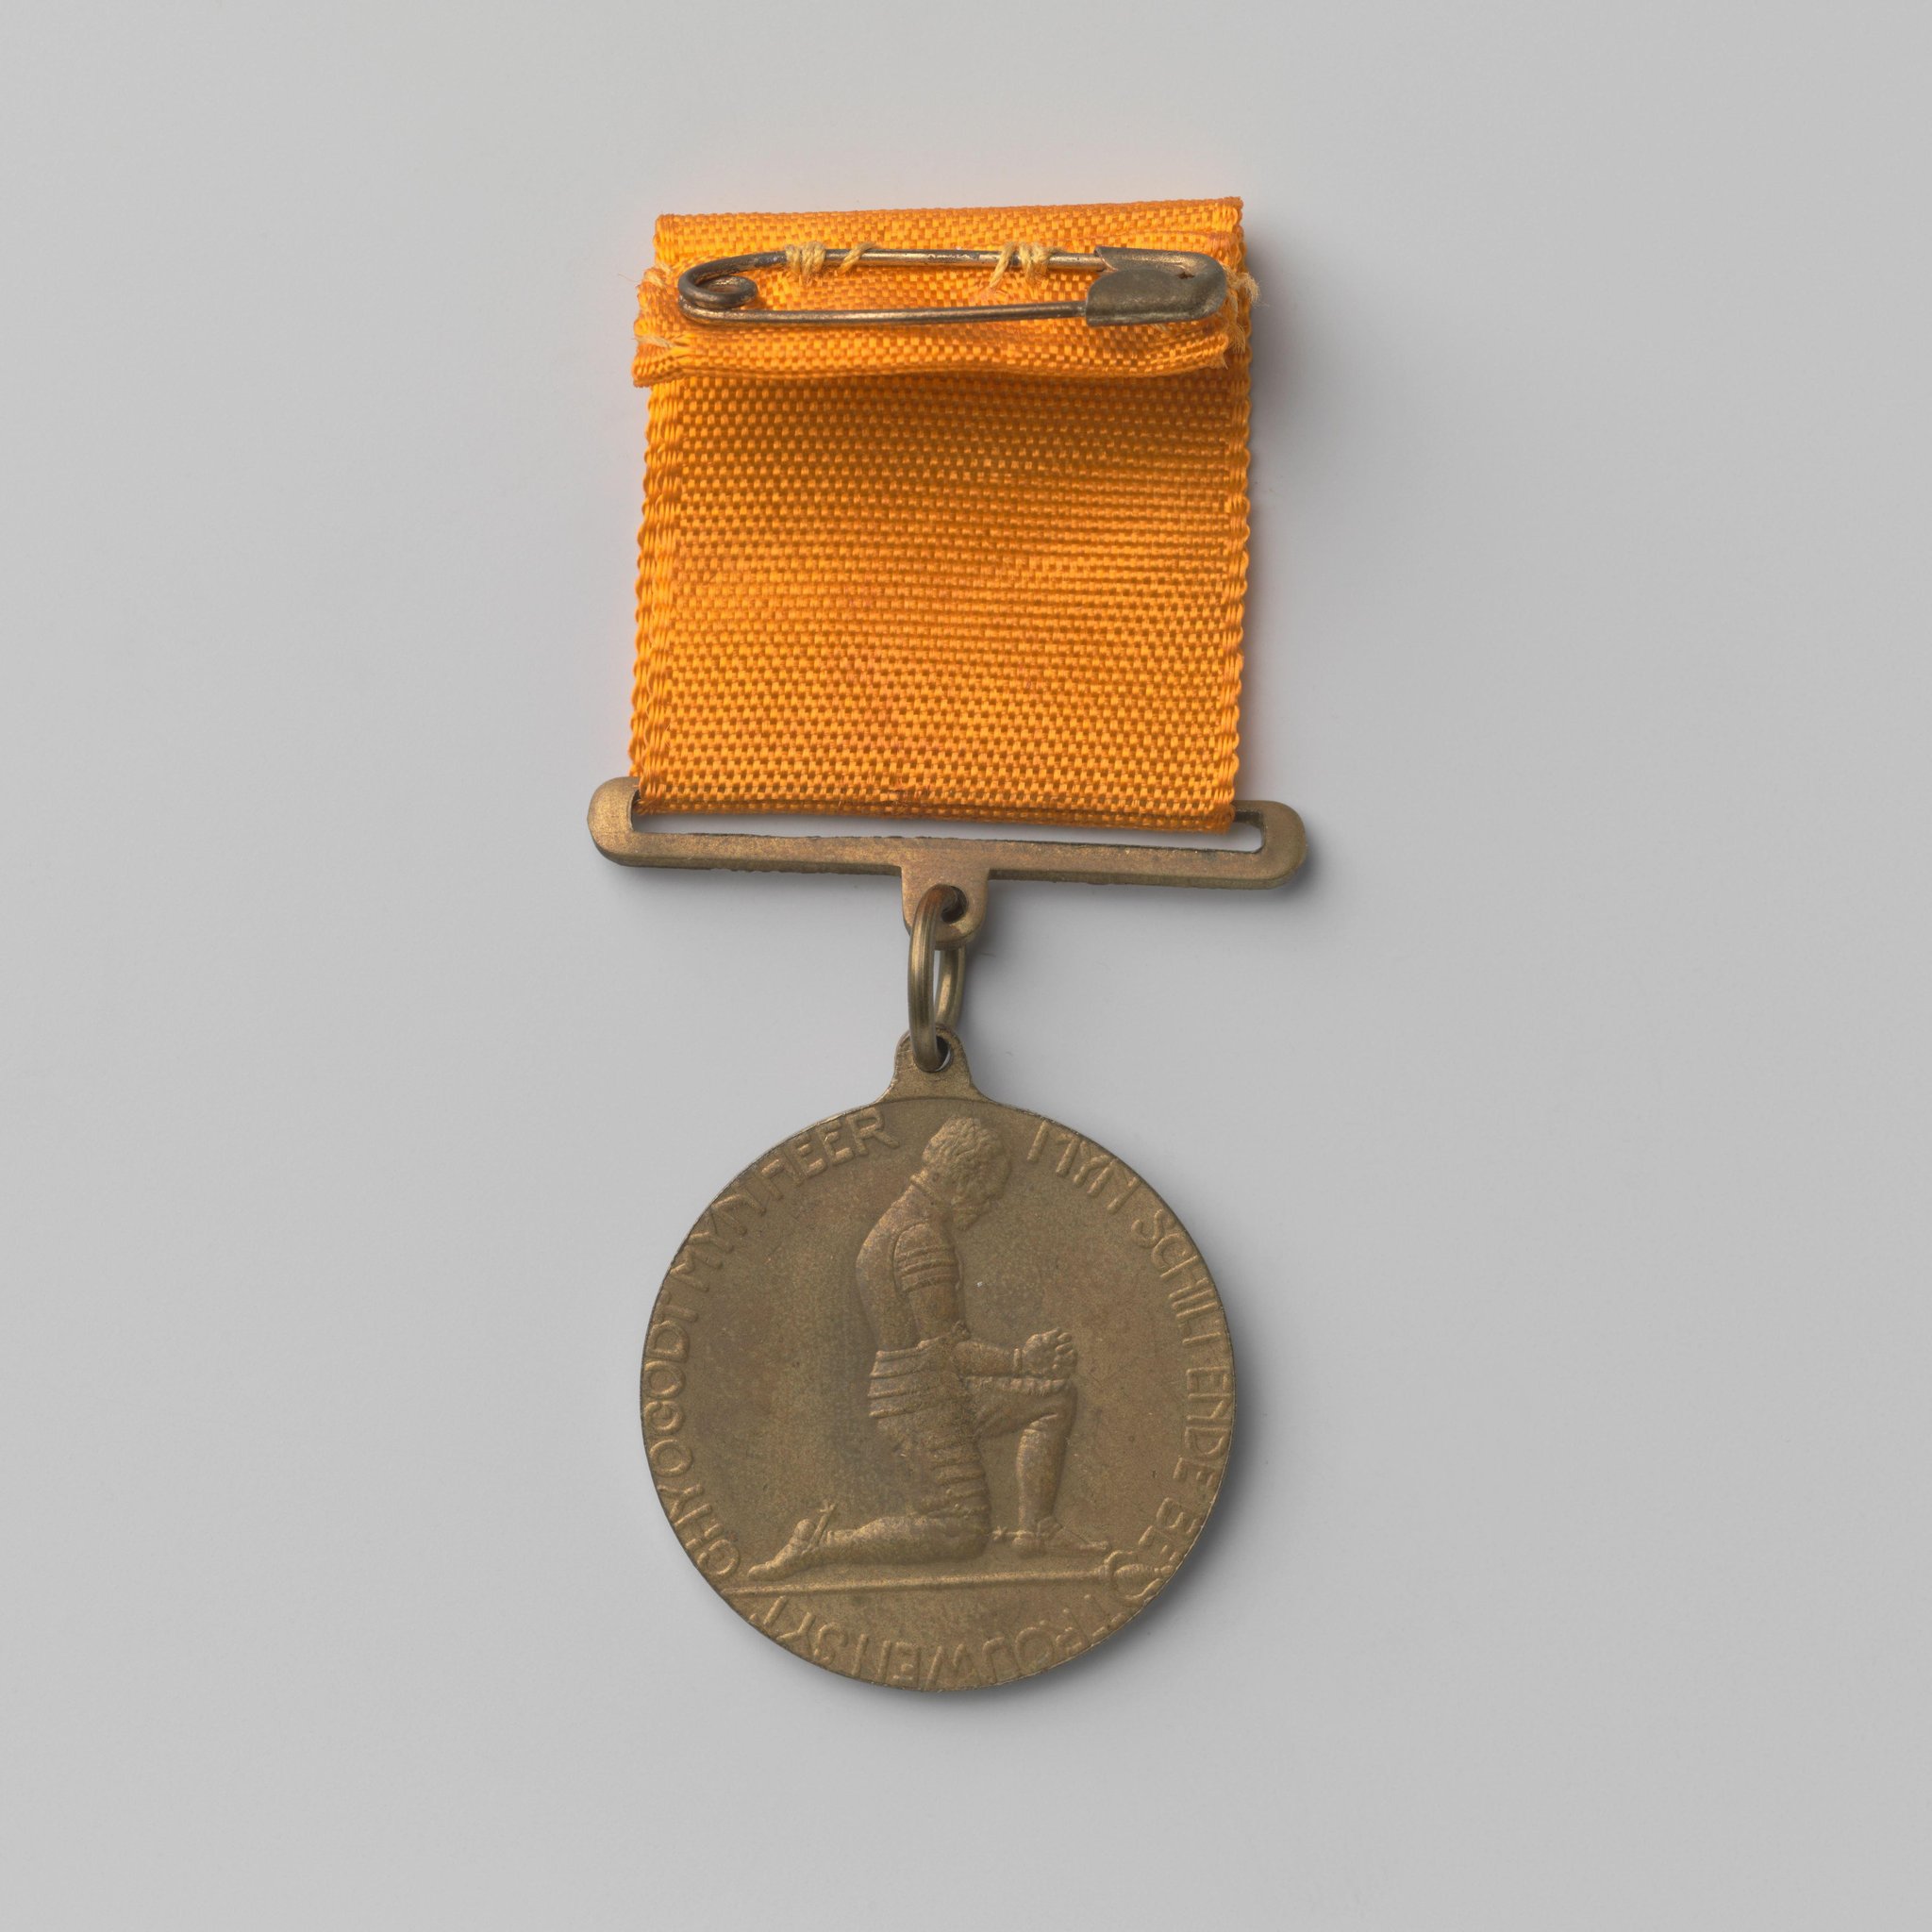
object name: history medal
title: Vierhonderdjarige herdenking van de geboorte van Willem van Oranje 1933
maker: oswald wenckebach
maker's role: draughtsman, print maker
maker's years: 1895-1962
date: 1933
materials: brass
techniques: striking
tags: delft, william i (prince of orange)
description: Messing draagpenning met oog en draagring aan oranje lint, op de voorzijde Willem knielend naar rechts met omschrift, op de keerzijde een vogel op een nest in de golven, met omschrift.